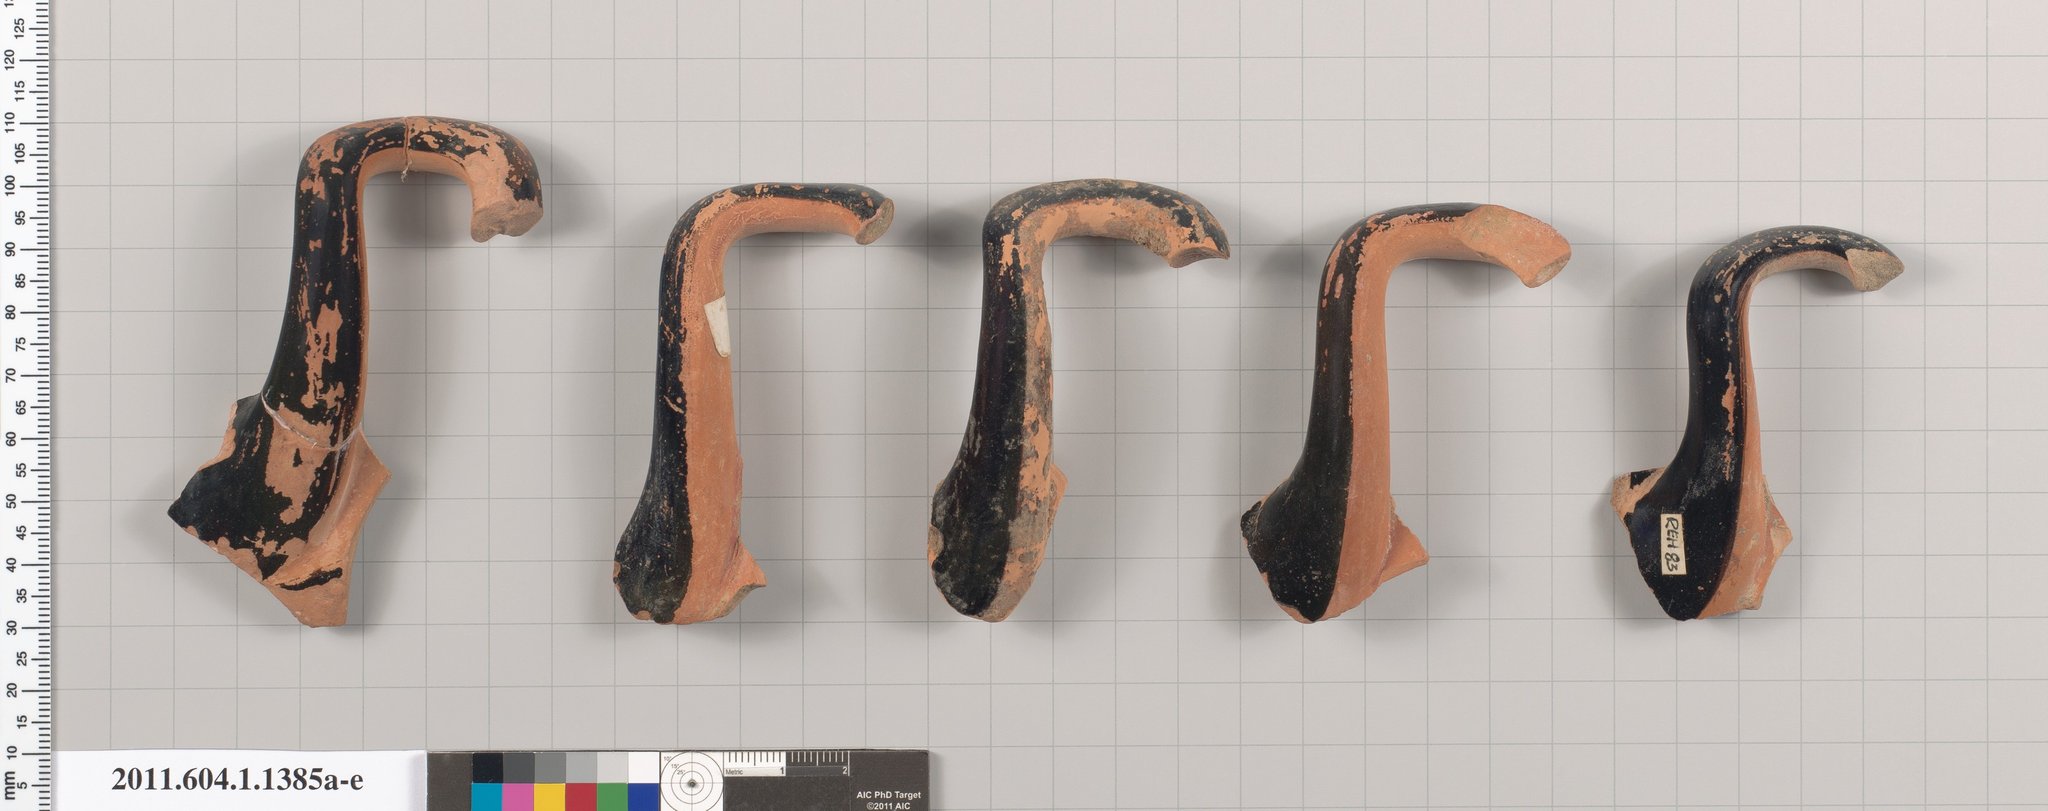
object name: kylix fragment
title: Terracotta fragments of kylikes (drinking cups)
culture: greek, attic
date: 500-401 BCE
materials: terracotta